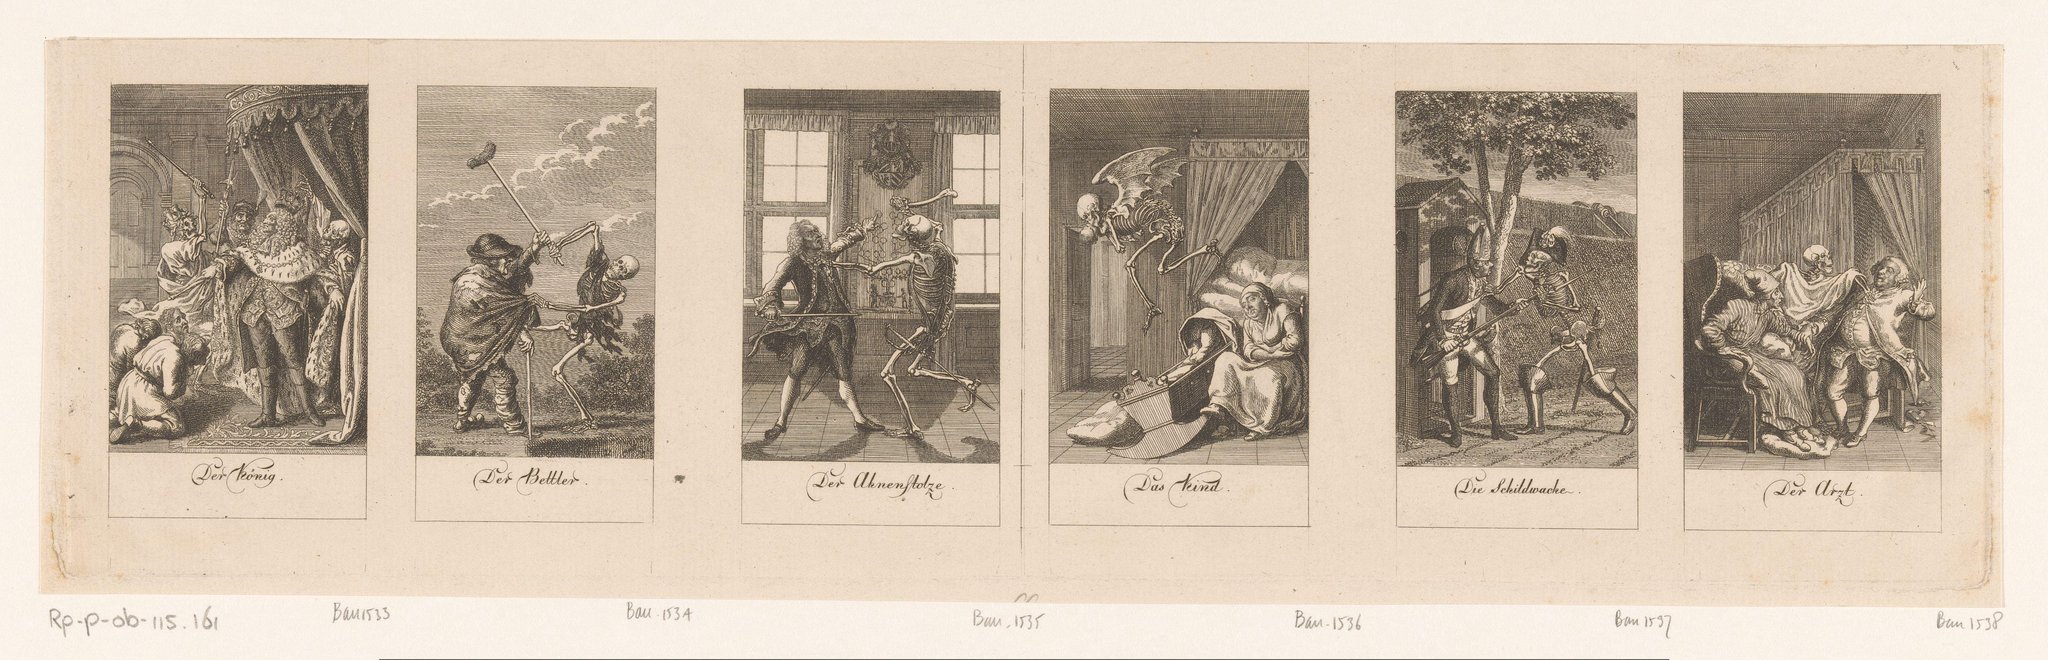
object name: print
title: Zes voorstellingen uit de dodendans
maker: daniel nikolaus chodowiecki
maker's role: draughtsman, print maker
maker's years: 1726-1801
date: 1791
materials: paper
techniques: etching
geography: berlin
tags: death as skeleton, family lineage, pedigree, genealogical tree or table, death dancing with one person, physician, doctor, the new-born child, ruler, sovereign, beggar, guard duty, keeping sentry, death of human being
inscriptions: collector's mark: Lugt 2228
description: Prent gebruikt voor: Königl. Grossbritannischer Historischer Genealogischer Calender für 1792. Lauenburg: Johann Georg Berenberg, [1791].